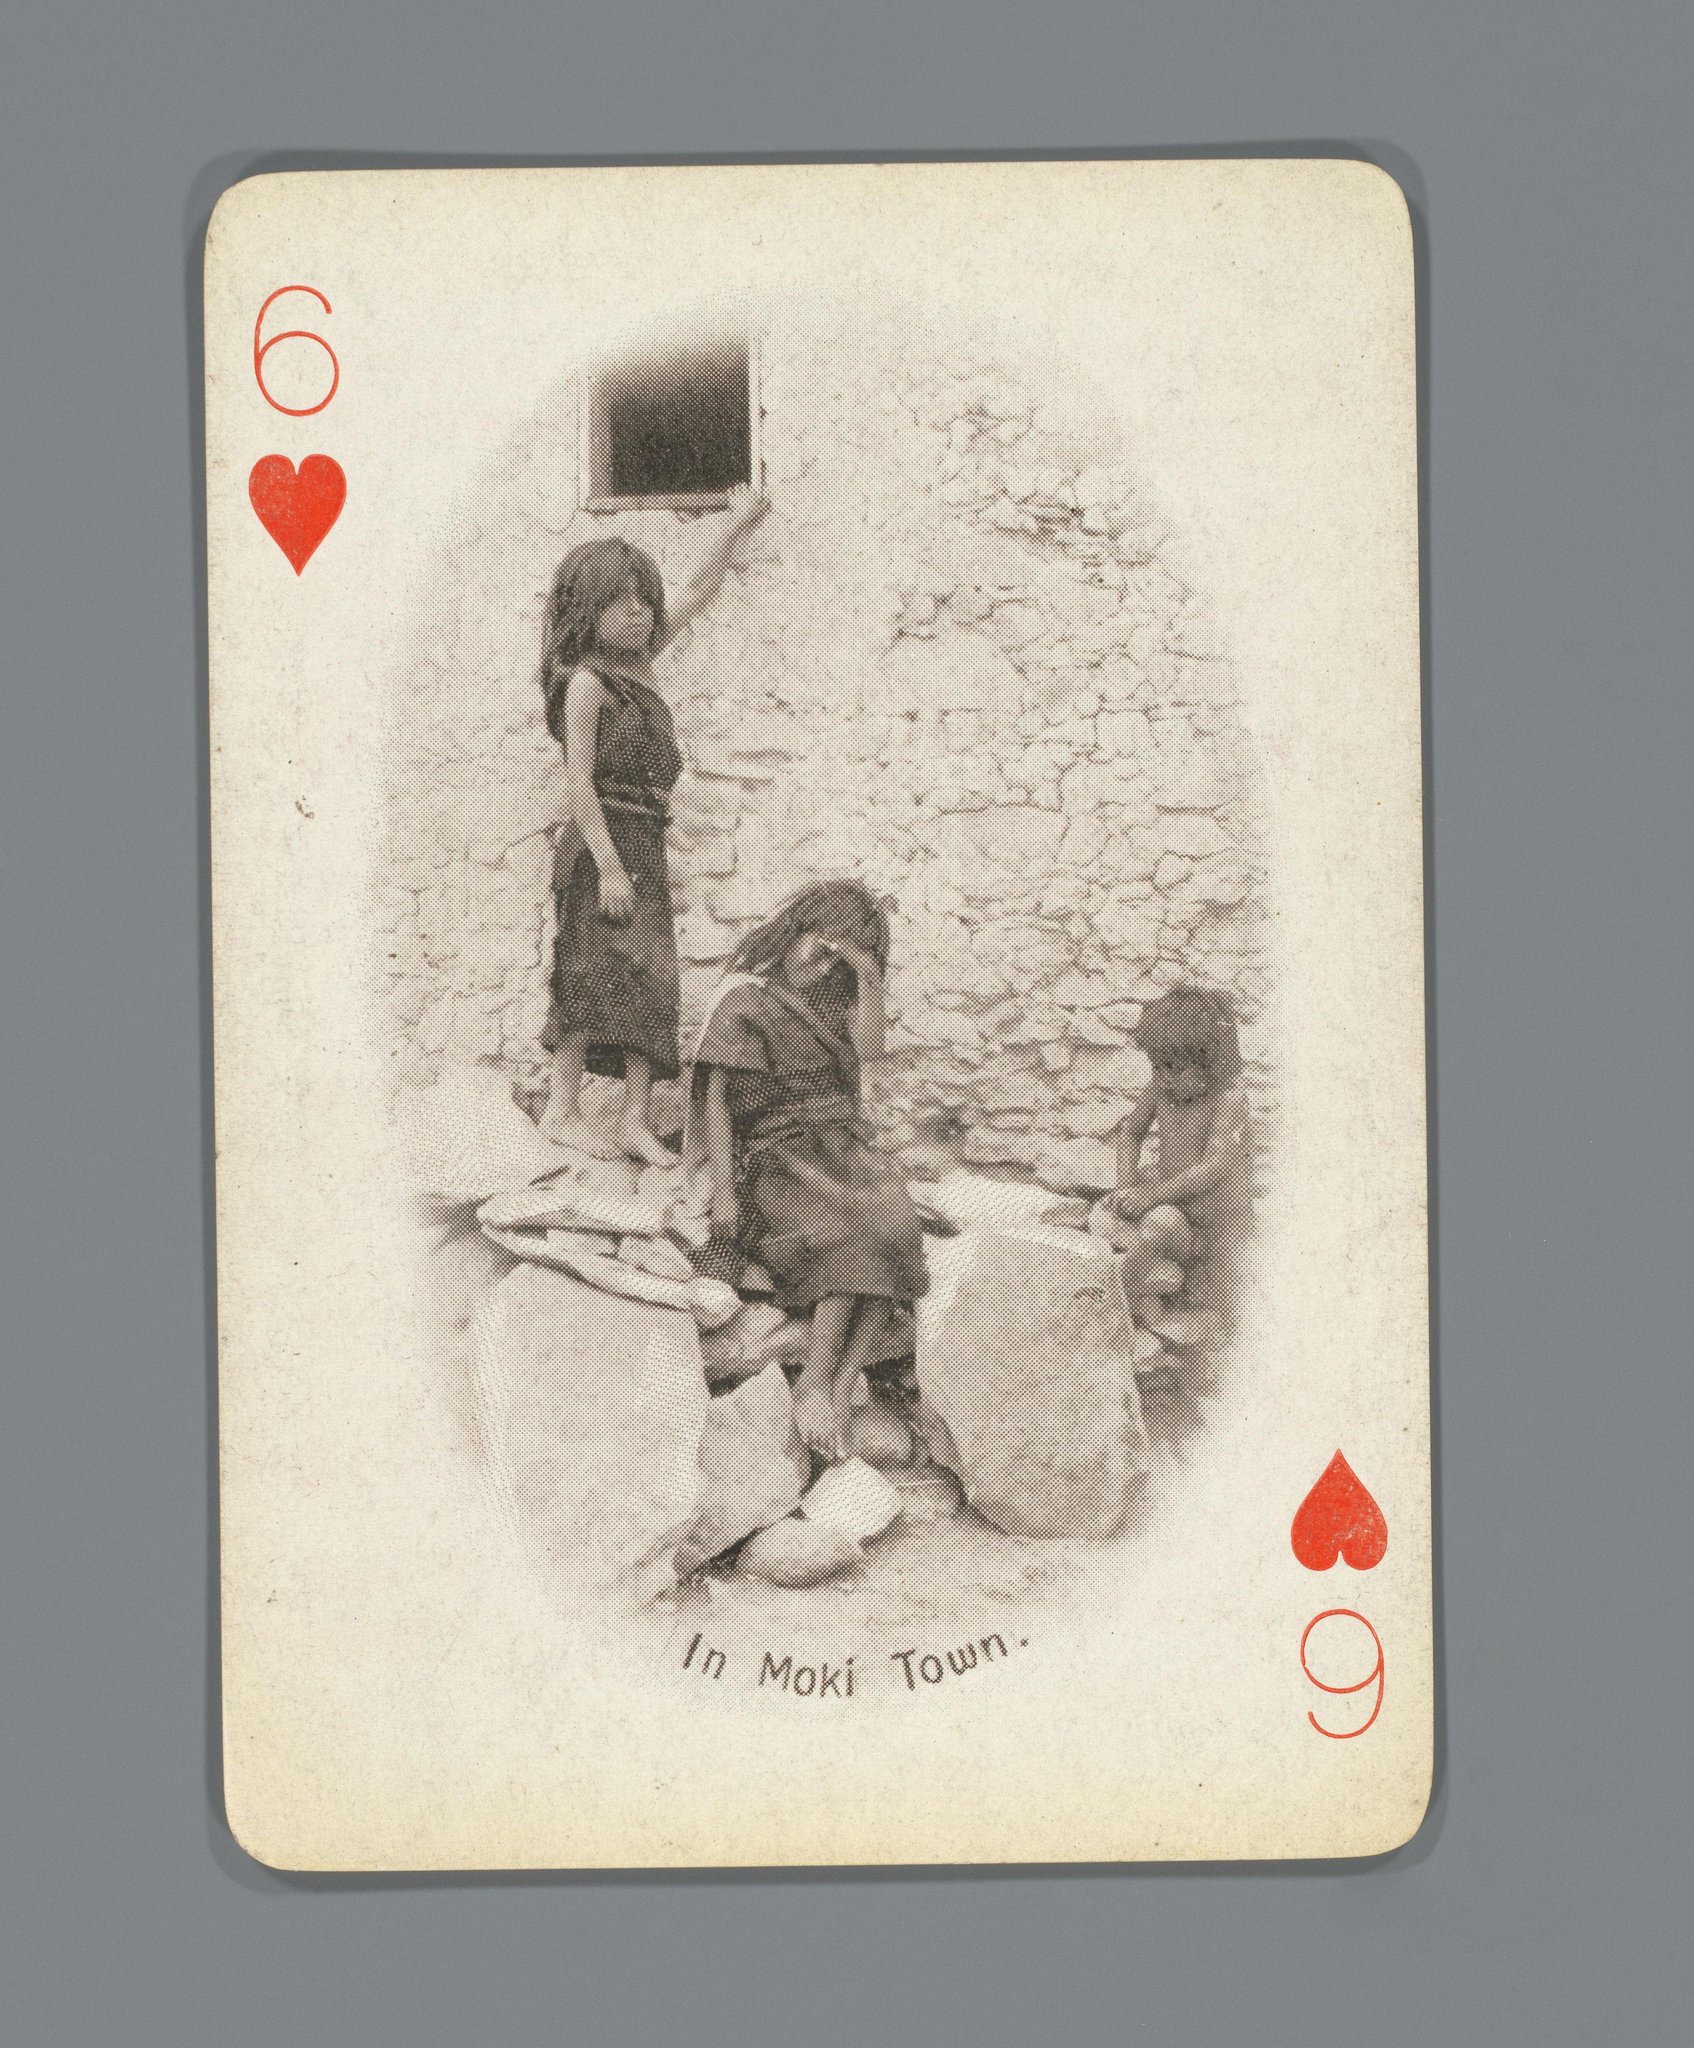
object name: playing card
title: Harten zes met drie kinderen uit Moki, Arizona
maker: adam clark vroman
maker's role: fotograaf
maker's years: 1856-1916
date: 1900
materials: paper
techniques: autotype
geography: los angeles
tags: arizona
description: Speelkaart uit doosje met 53 speelkaarten met afbeeldingen in autotypie van Native Americans. De inhoud bevat een complete set speelkaarten inclusief joker.